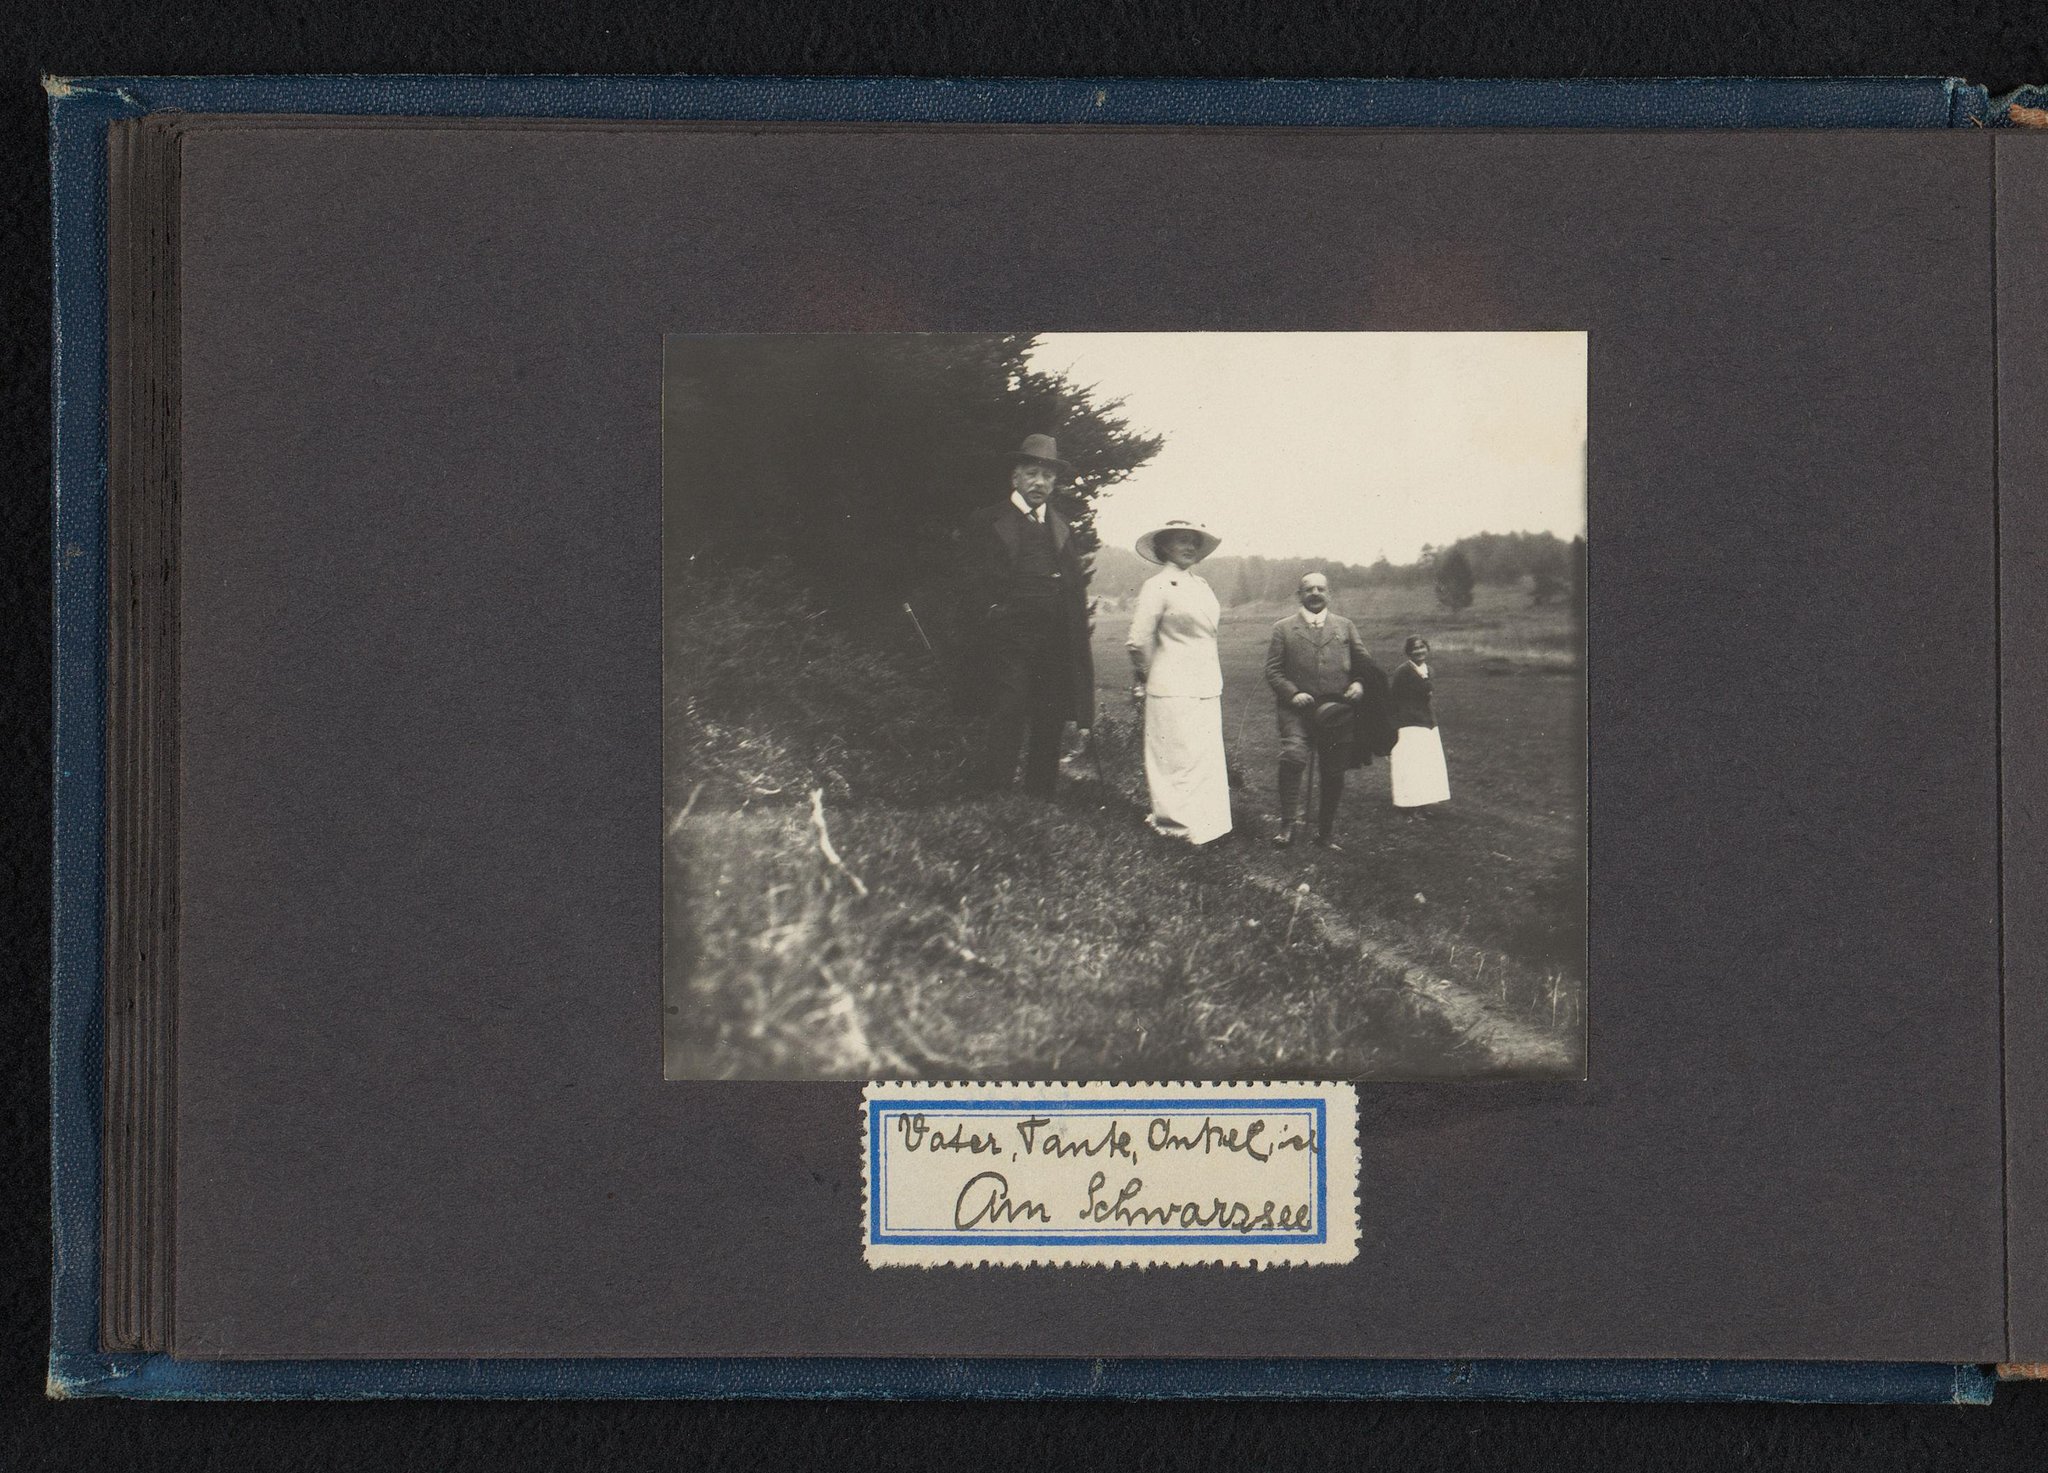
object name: album leaf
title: Wandeling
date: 1913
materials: paper, photographic support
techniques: gelatin silver print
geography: switzerland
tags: else wachenheimer-moos, the family travelling, on holiday, walking, hiking (recreation), switzerland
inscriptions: inscription: ‘Vater, Tante, Onkel, ich / Am Schwarzsee’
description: Albumblad met een foto van Else en familieleden tijdens een wandeling, in Zwitserland. Onderdeel van het fotoalbum van Else Wachenheimer-Moos en haar broers Arthur en Willy Moos en anderen in de periode 1913-1918.